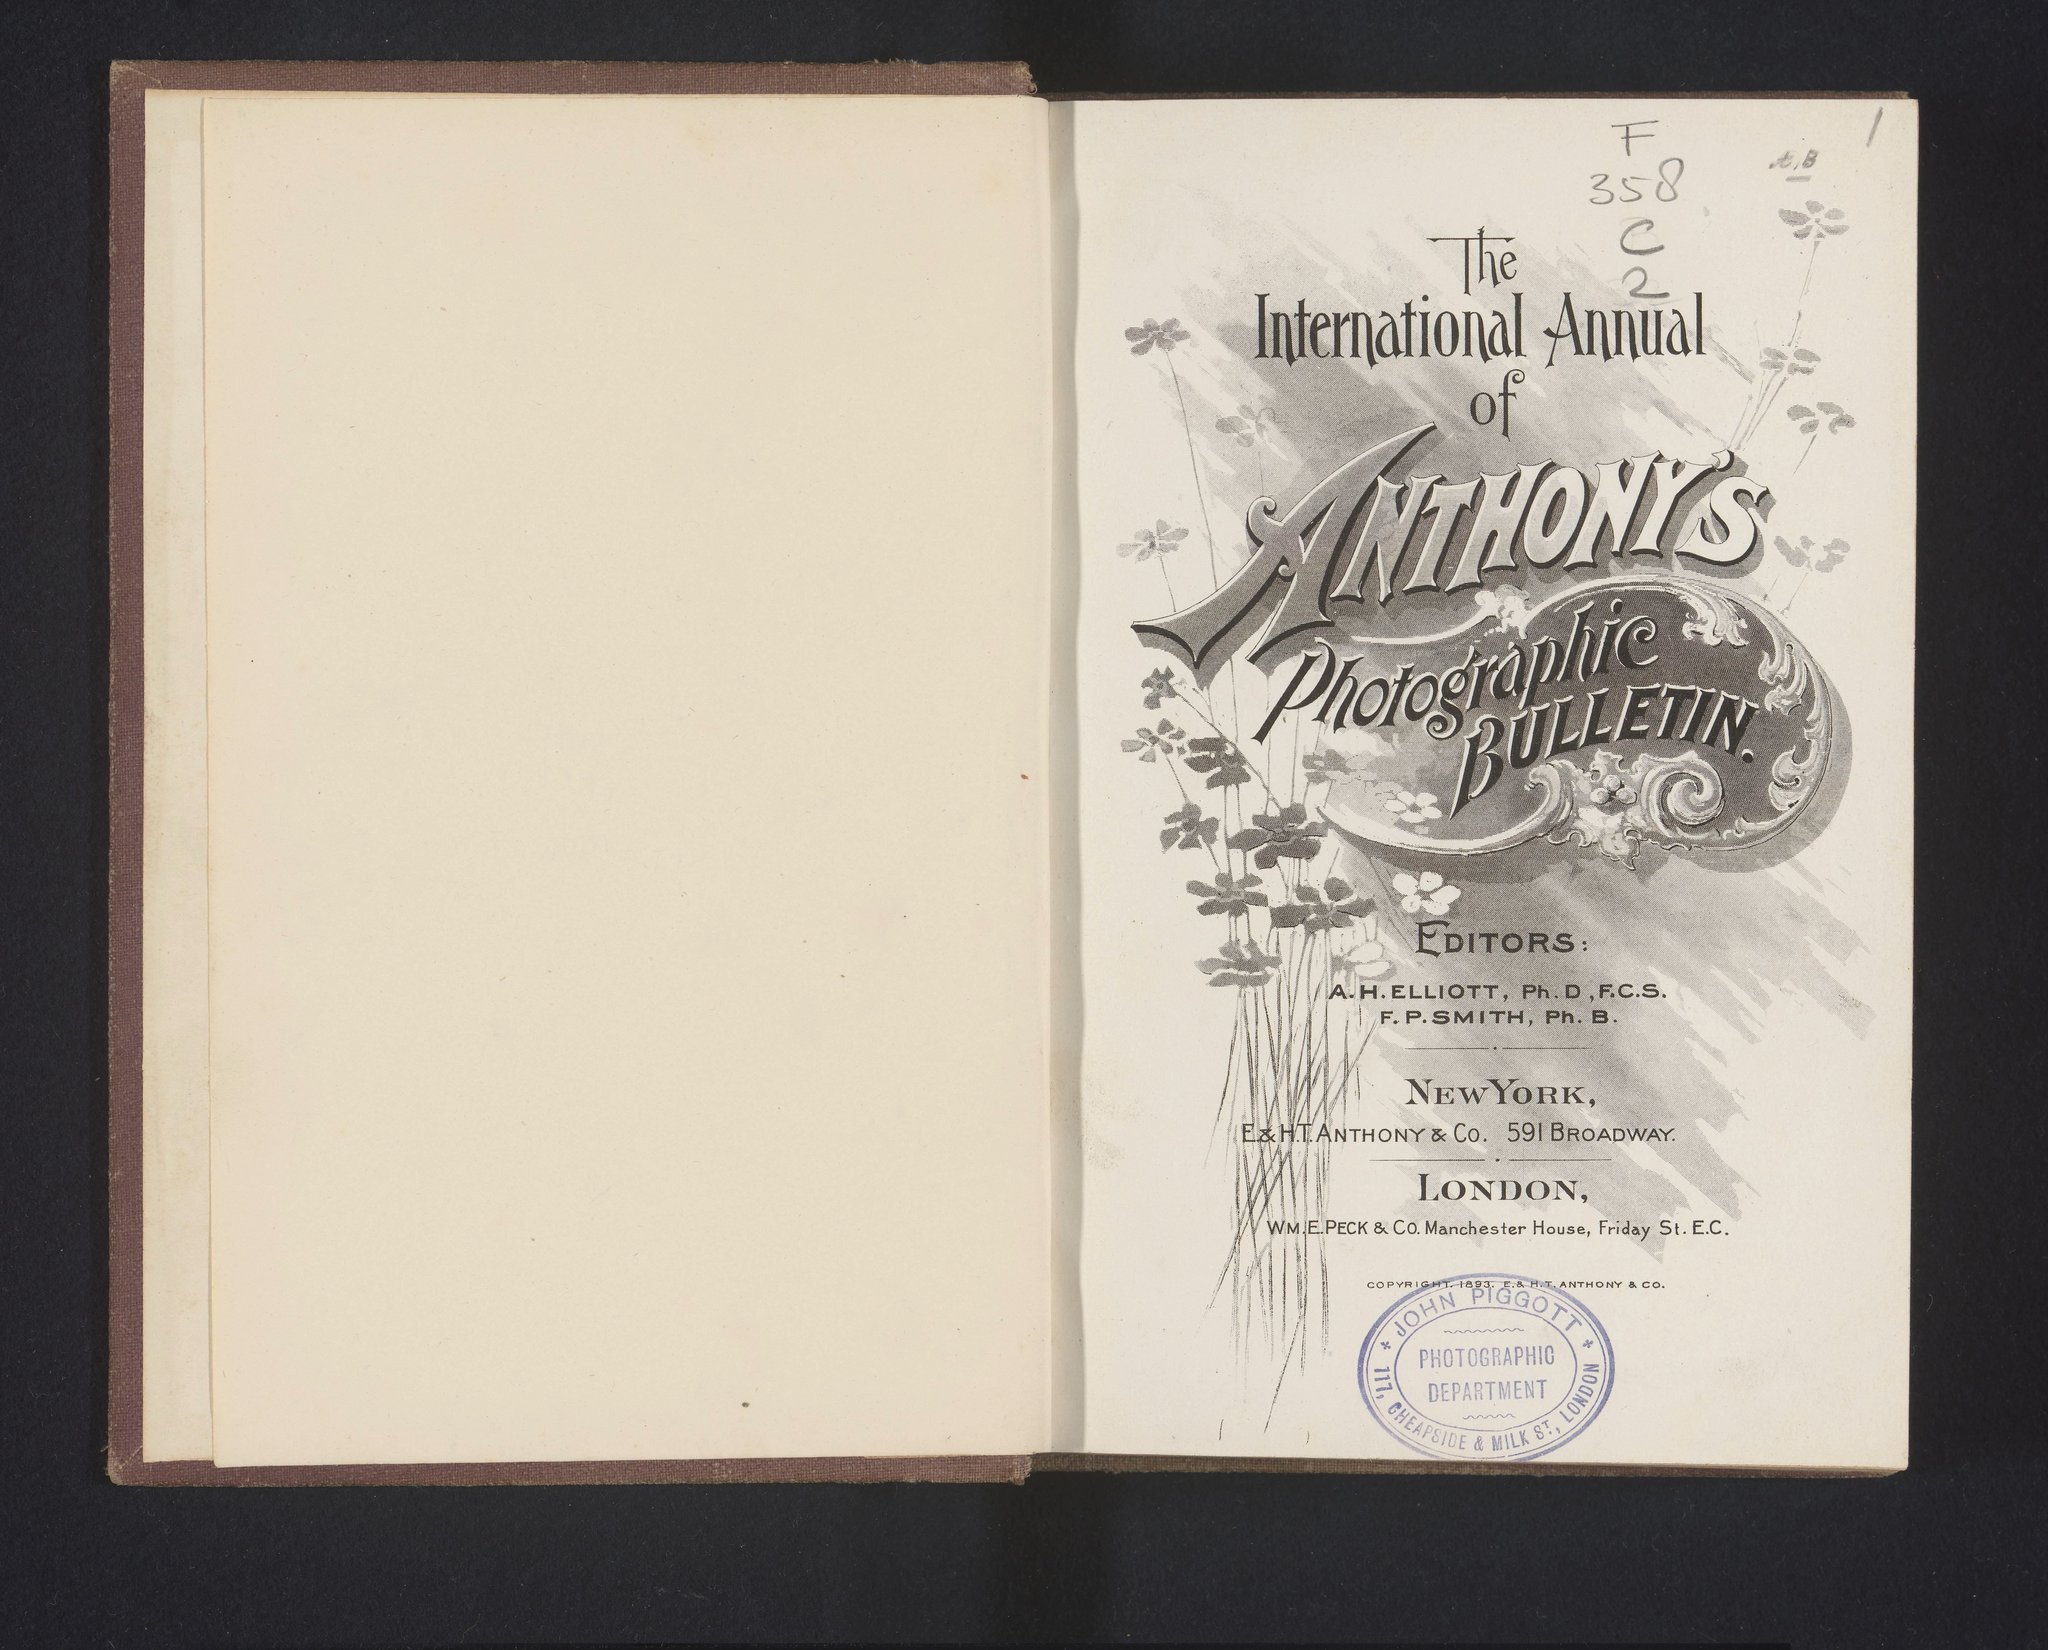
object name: book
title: The international annual of Anthony's photographic bulletin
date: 1893-1895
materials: cardboard, linen, paper, photographic support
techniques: photograph, photoaquatint, printing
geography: london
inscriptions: inscription: ‘John Piggot Photographic department 117, Cheapside & milk St., London’